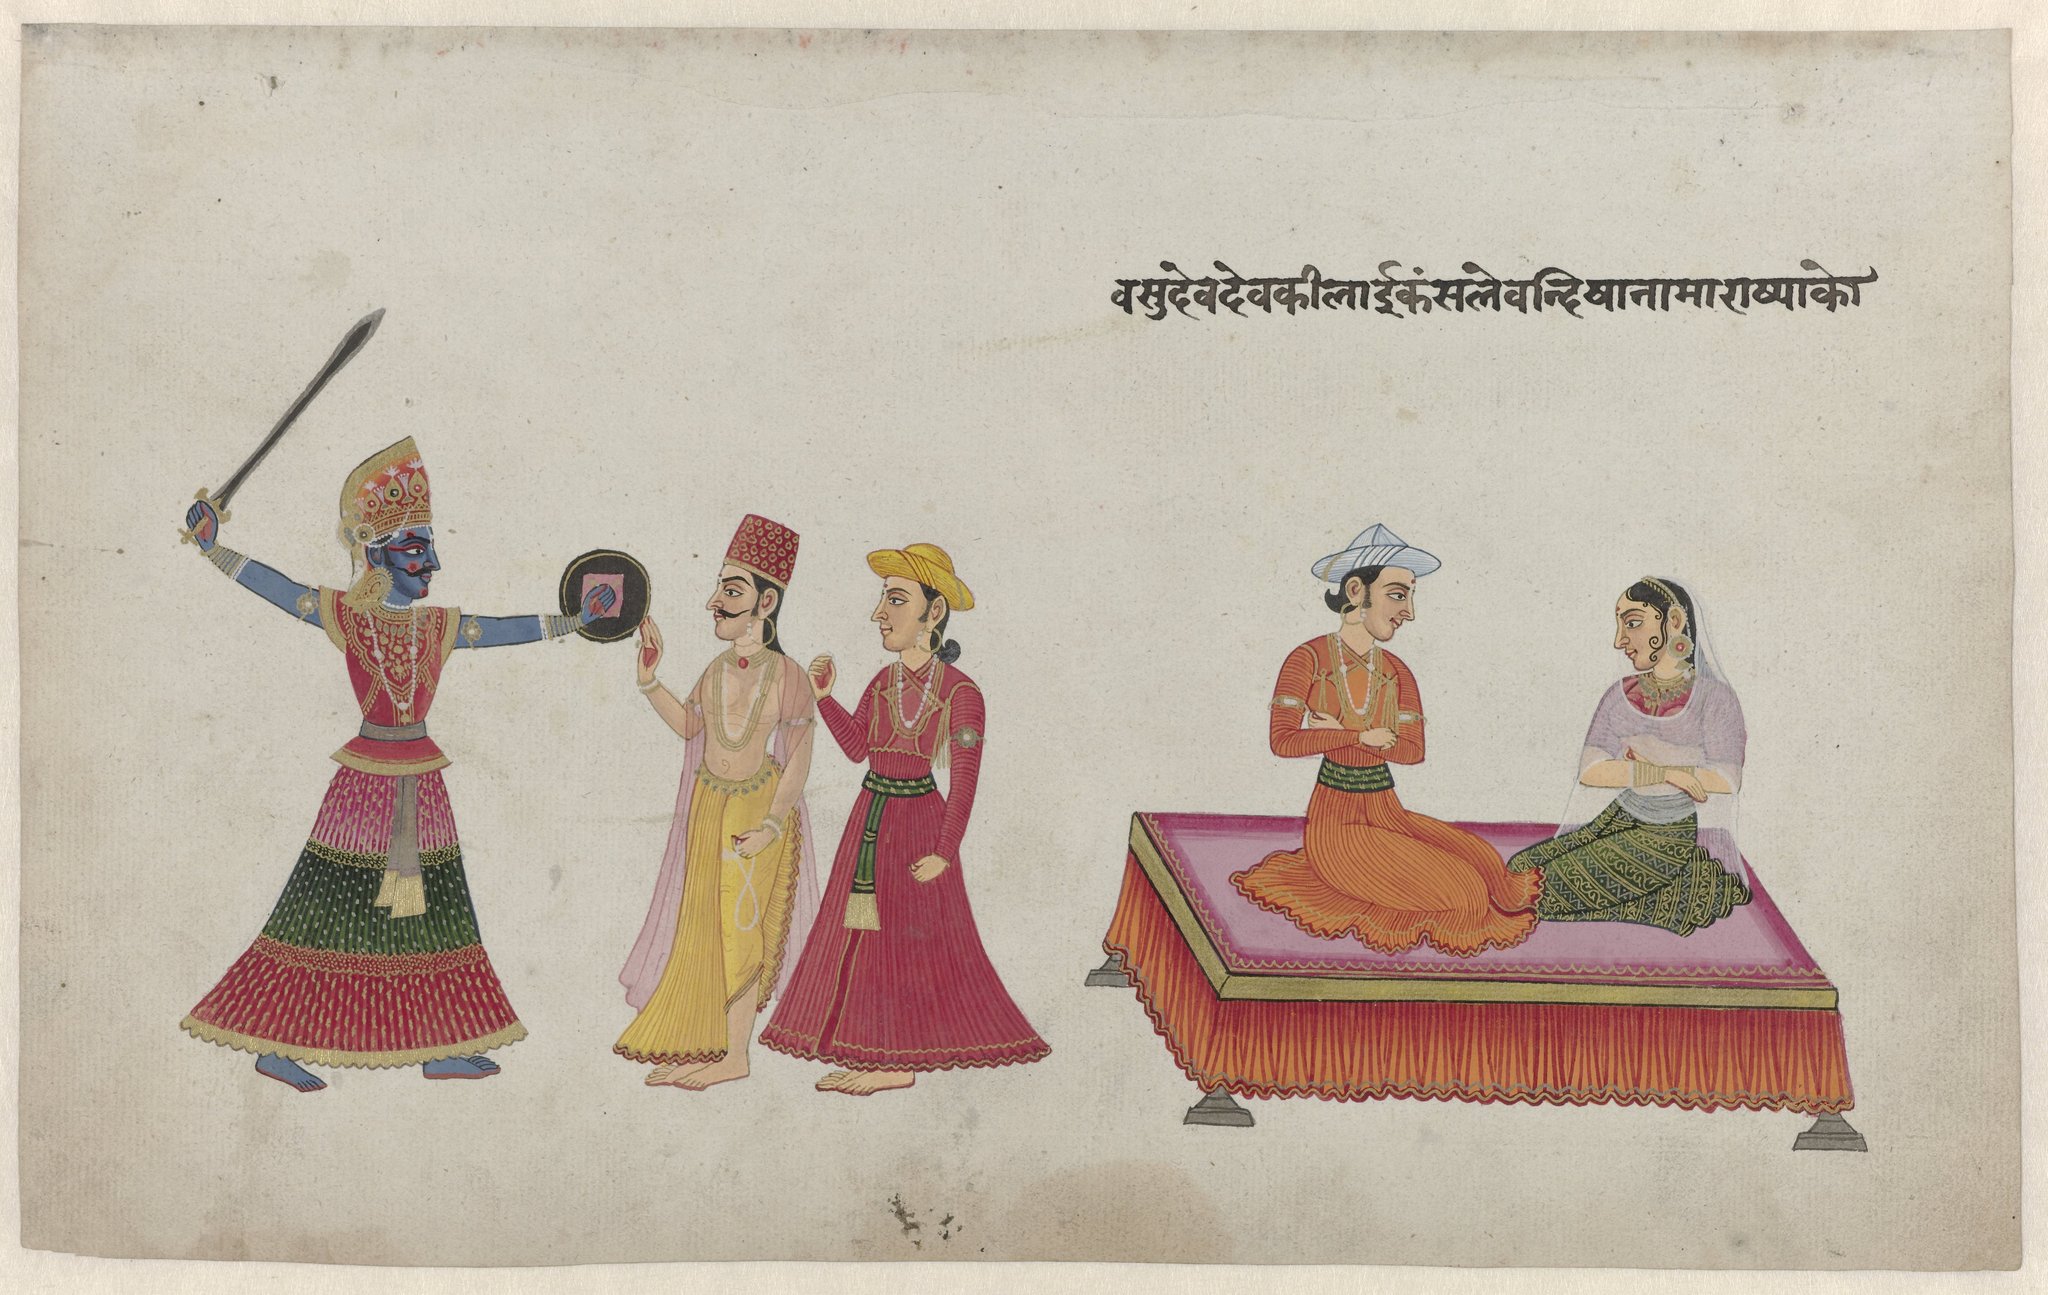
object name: drawing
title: Koning Kamsa, Vasudeva en Devaki en twee andere figuren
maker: Anonymous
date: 1820-1849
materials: paper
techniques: brush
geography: nepal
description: Koning Kamsa staat links met geheven armen waarin hij een degen en een schild omhoog houdt, recht voor hem staan twee mannen die hun rechterhand sussend omhooghouden en rechts op het blad zit een echtpaar op een taboeret; boven hen een tekst in oud-Indisch schrift.